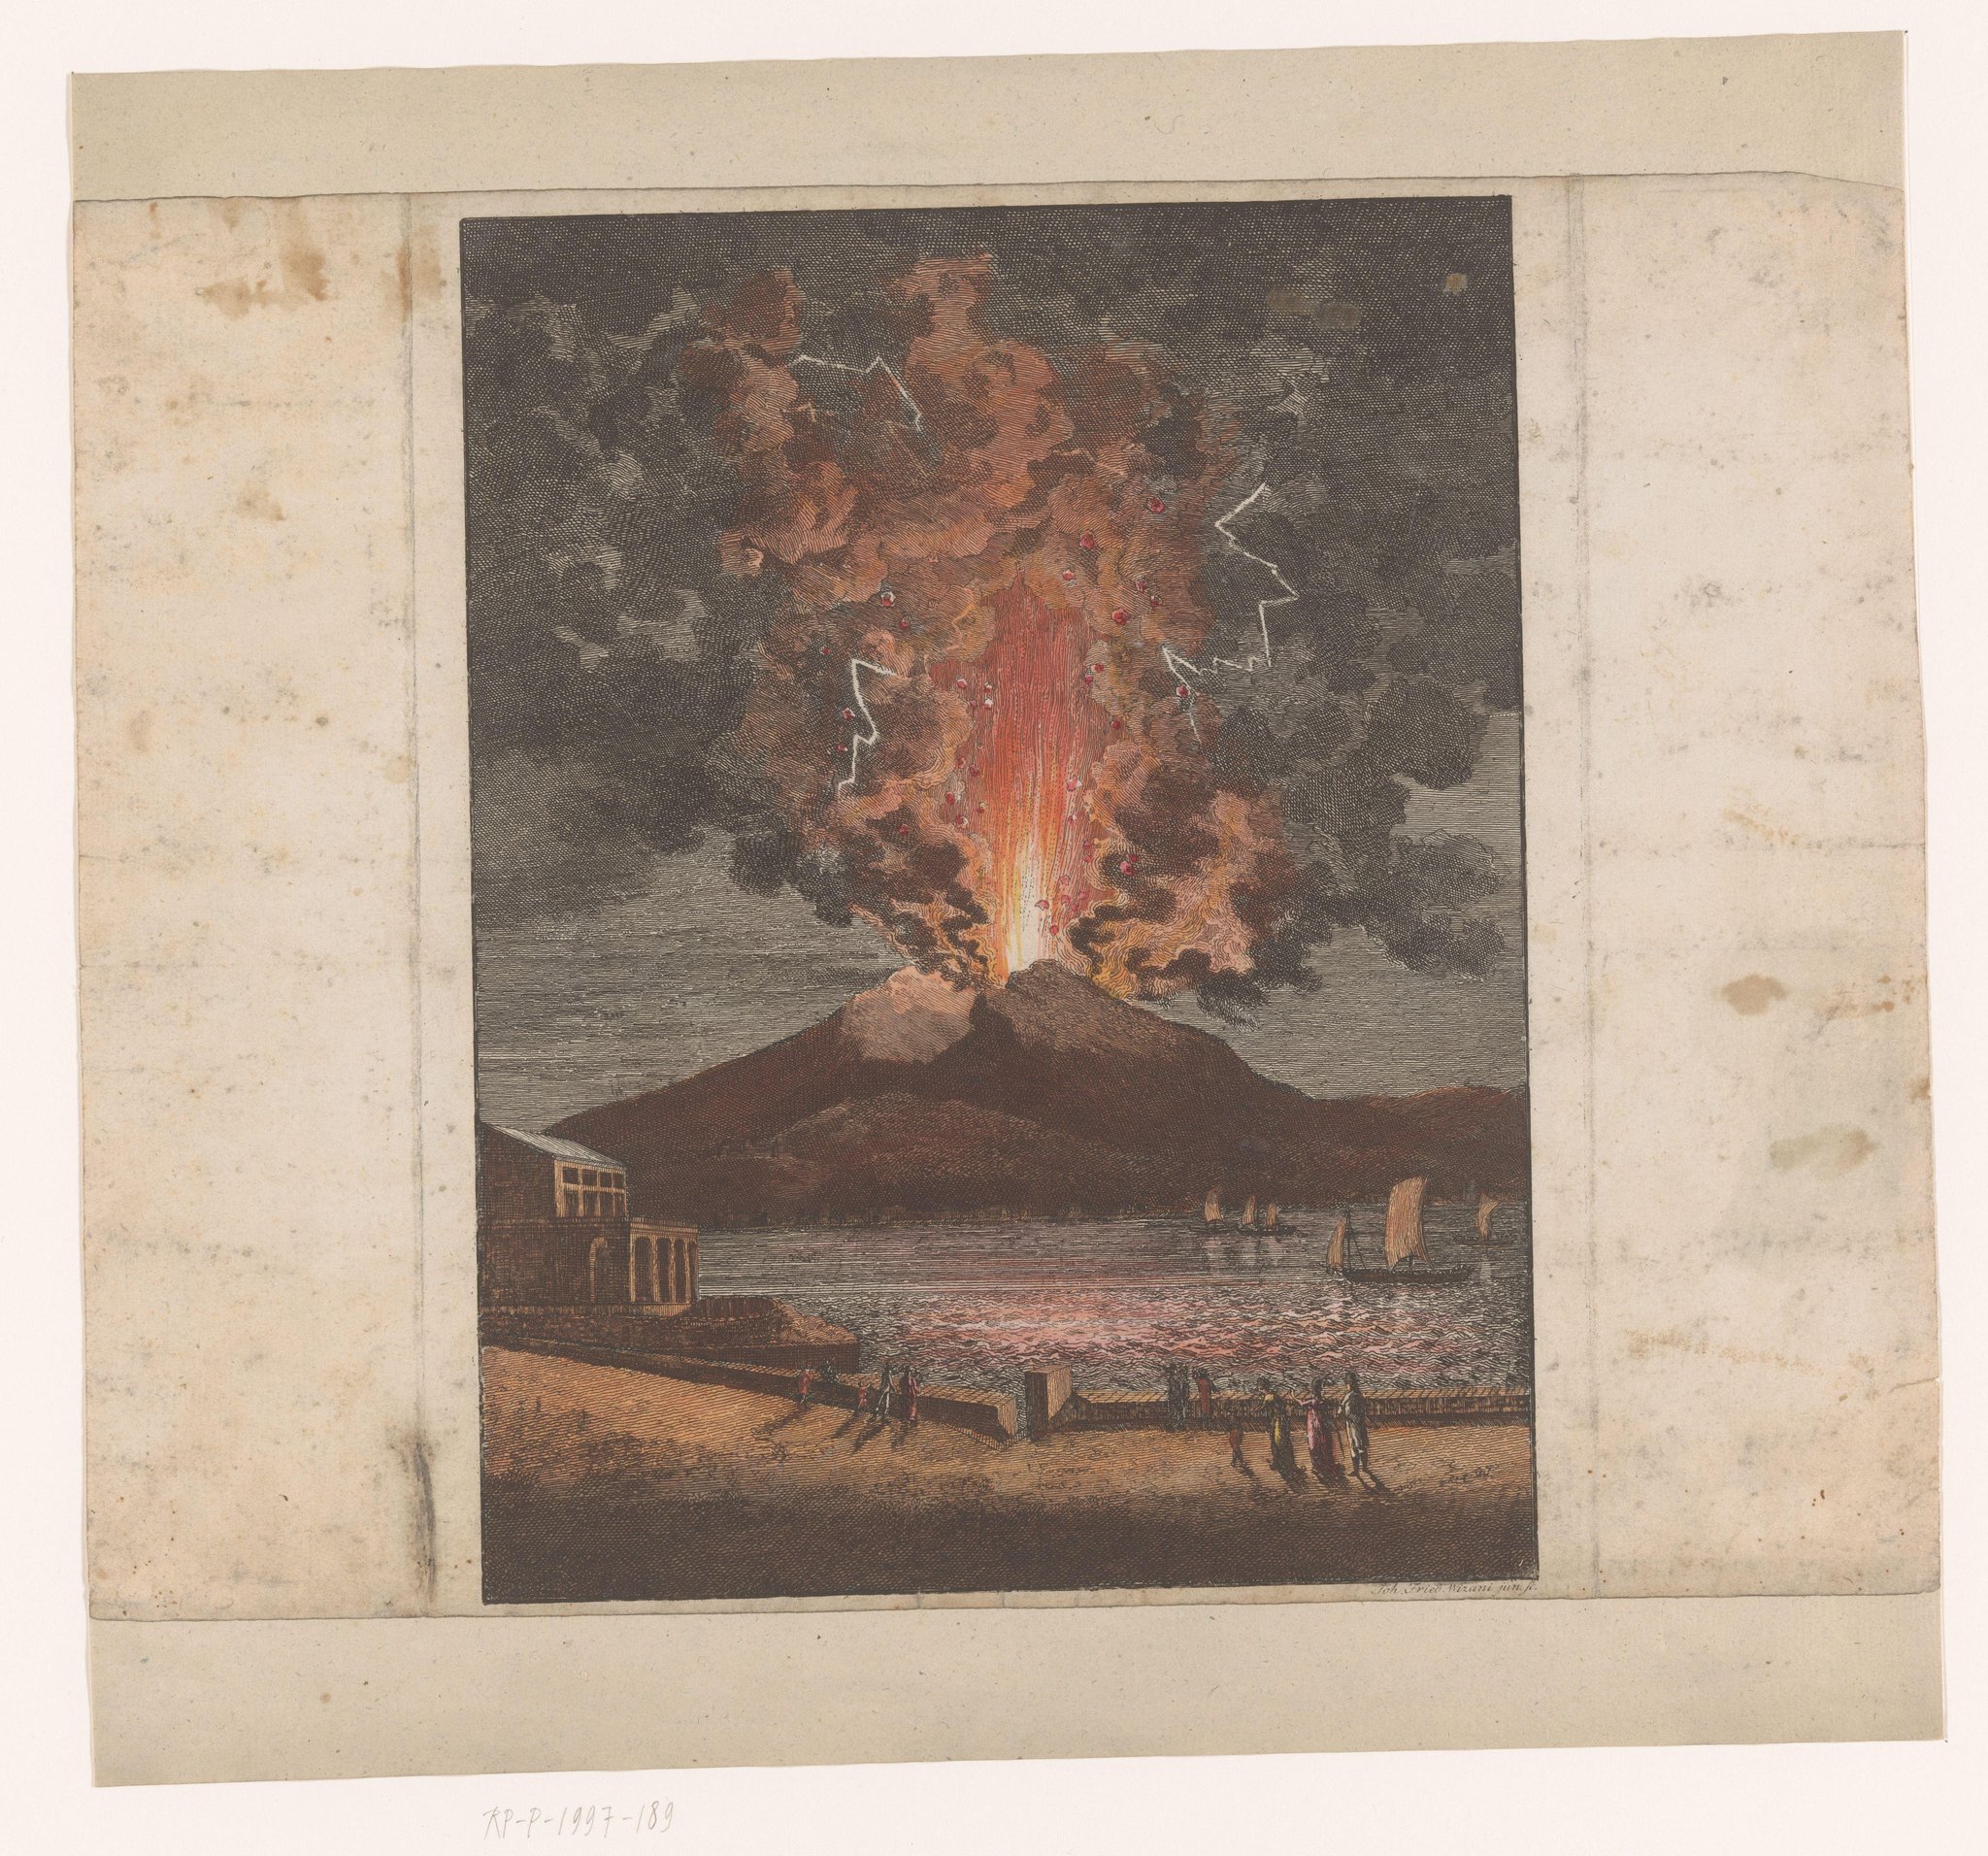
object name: print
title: Uitbarsting van een vulkaan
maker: johann friedrich wizani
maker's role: print maker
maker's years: 1770-1835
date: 1825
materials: paper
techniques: etching, hand coloring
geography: germany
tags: sailing-ship, sailing-boat, pier, quay, wharf, eruption (of volcano)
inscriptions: collector's mark: Lugt 2228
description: Aan de bovenzijde en onderzijde van het blad is een strook papier gemonteerd.